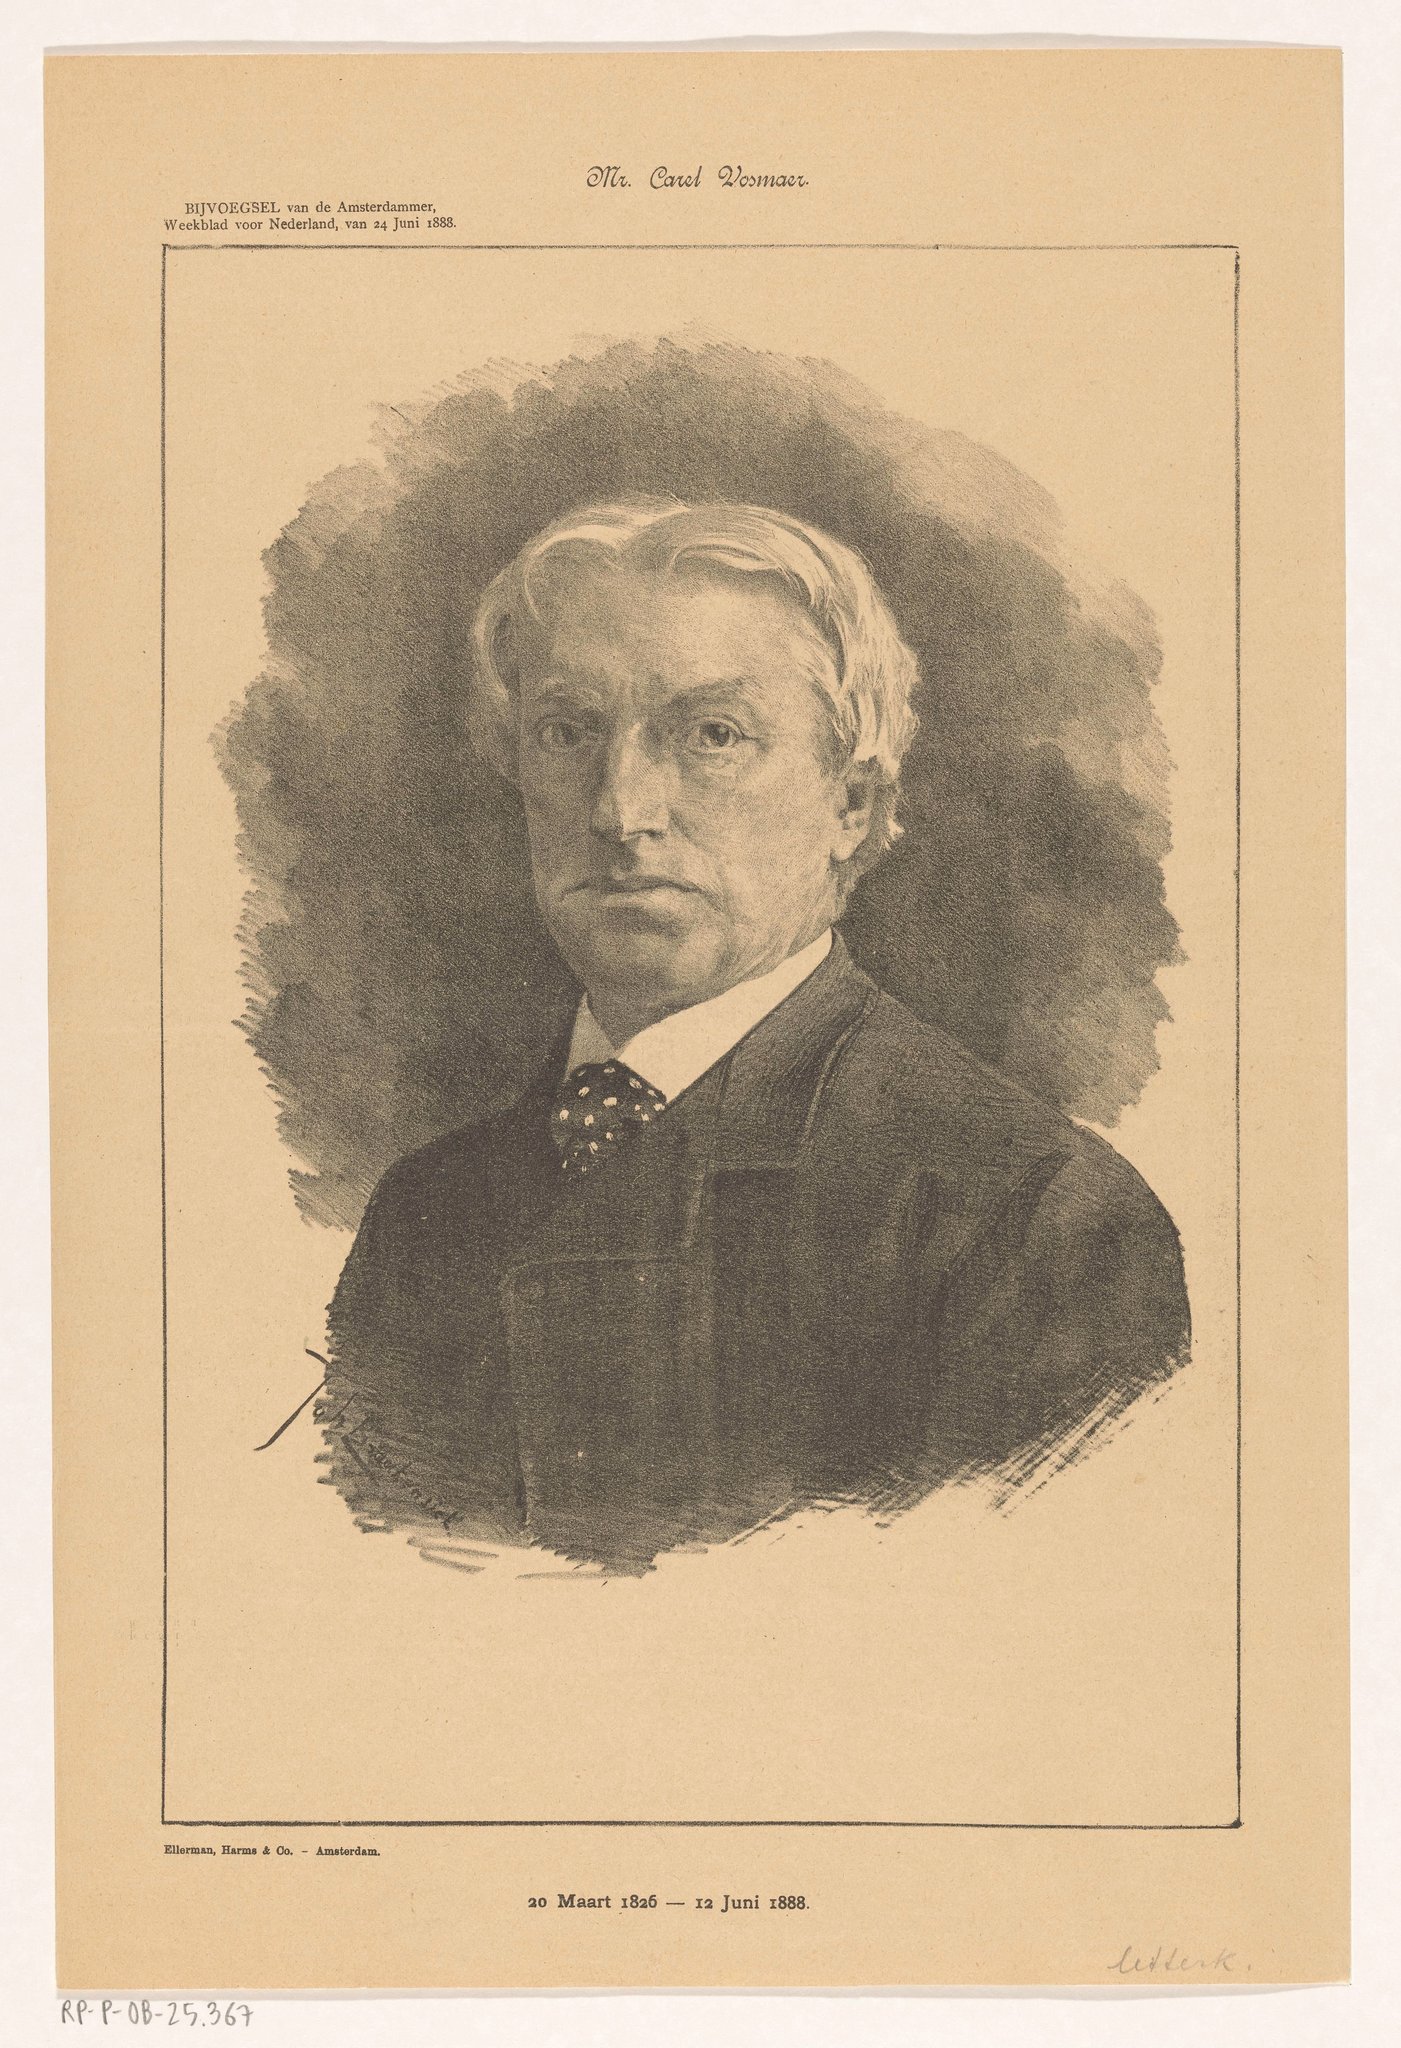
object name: print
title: Mr. Carel Vosmaer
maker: johan braakensiek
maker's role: draughtsman, print maker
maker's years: 1858-1940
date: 1888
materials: paper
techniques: lithograph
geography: amsterdam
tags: the hague, print maker, draughtsman, carel vosmaer, portrait of a writer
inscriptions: collector's mark: Lugt 2228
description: Verschenen in het bijvoegsel van 'De Amsterdammer, Weekblad voor Nederland' van 24 juni 1888.